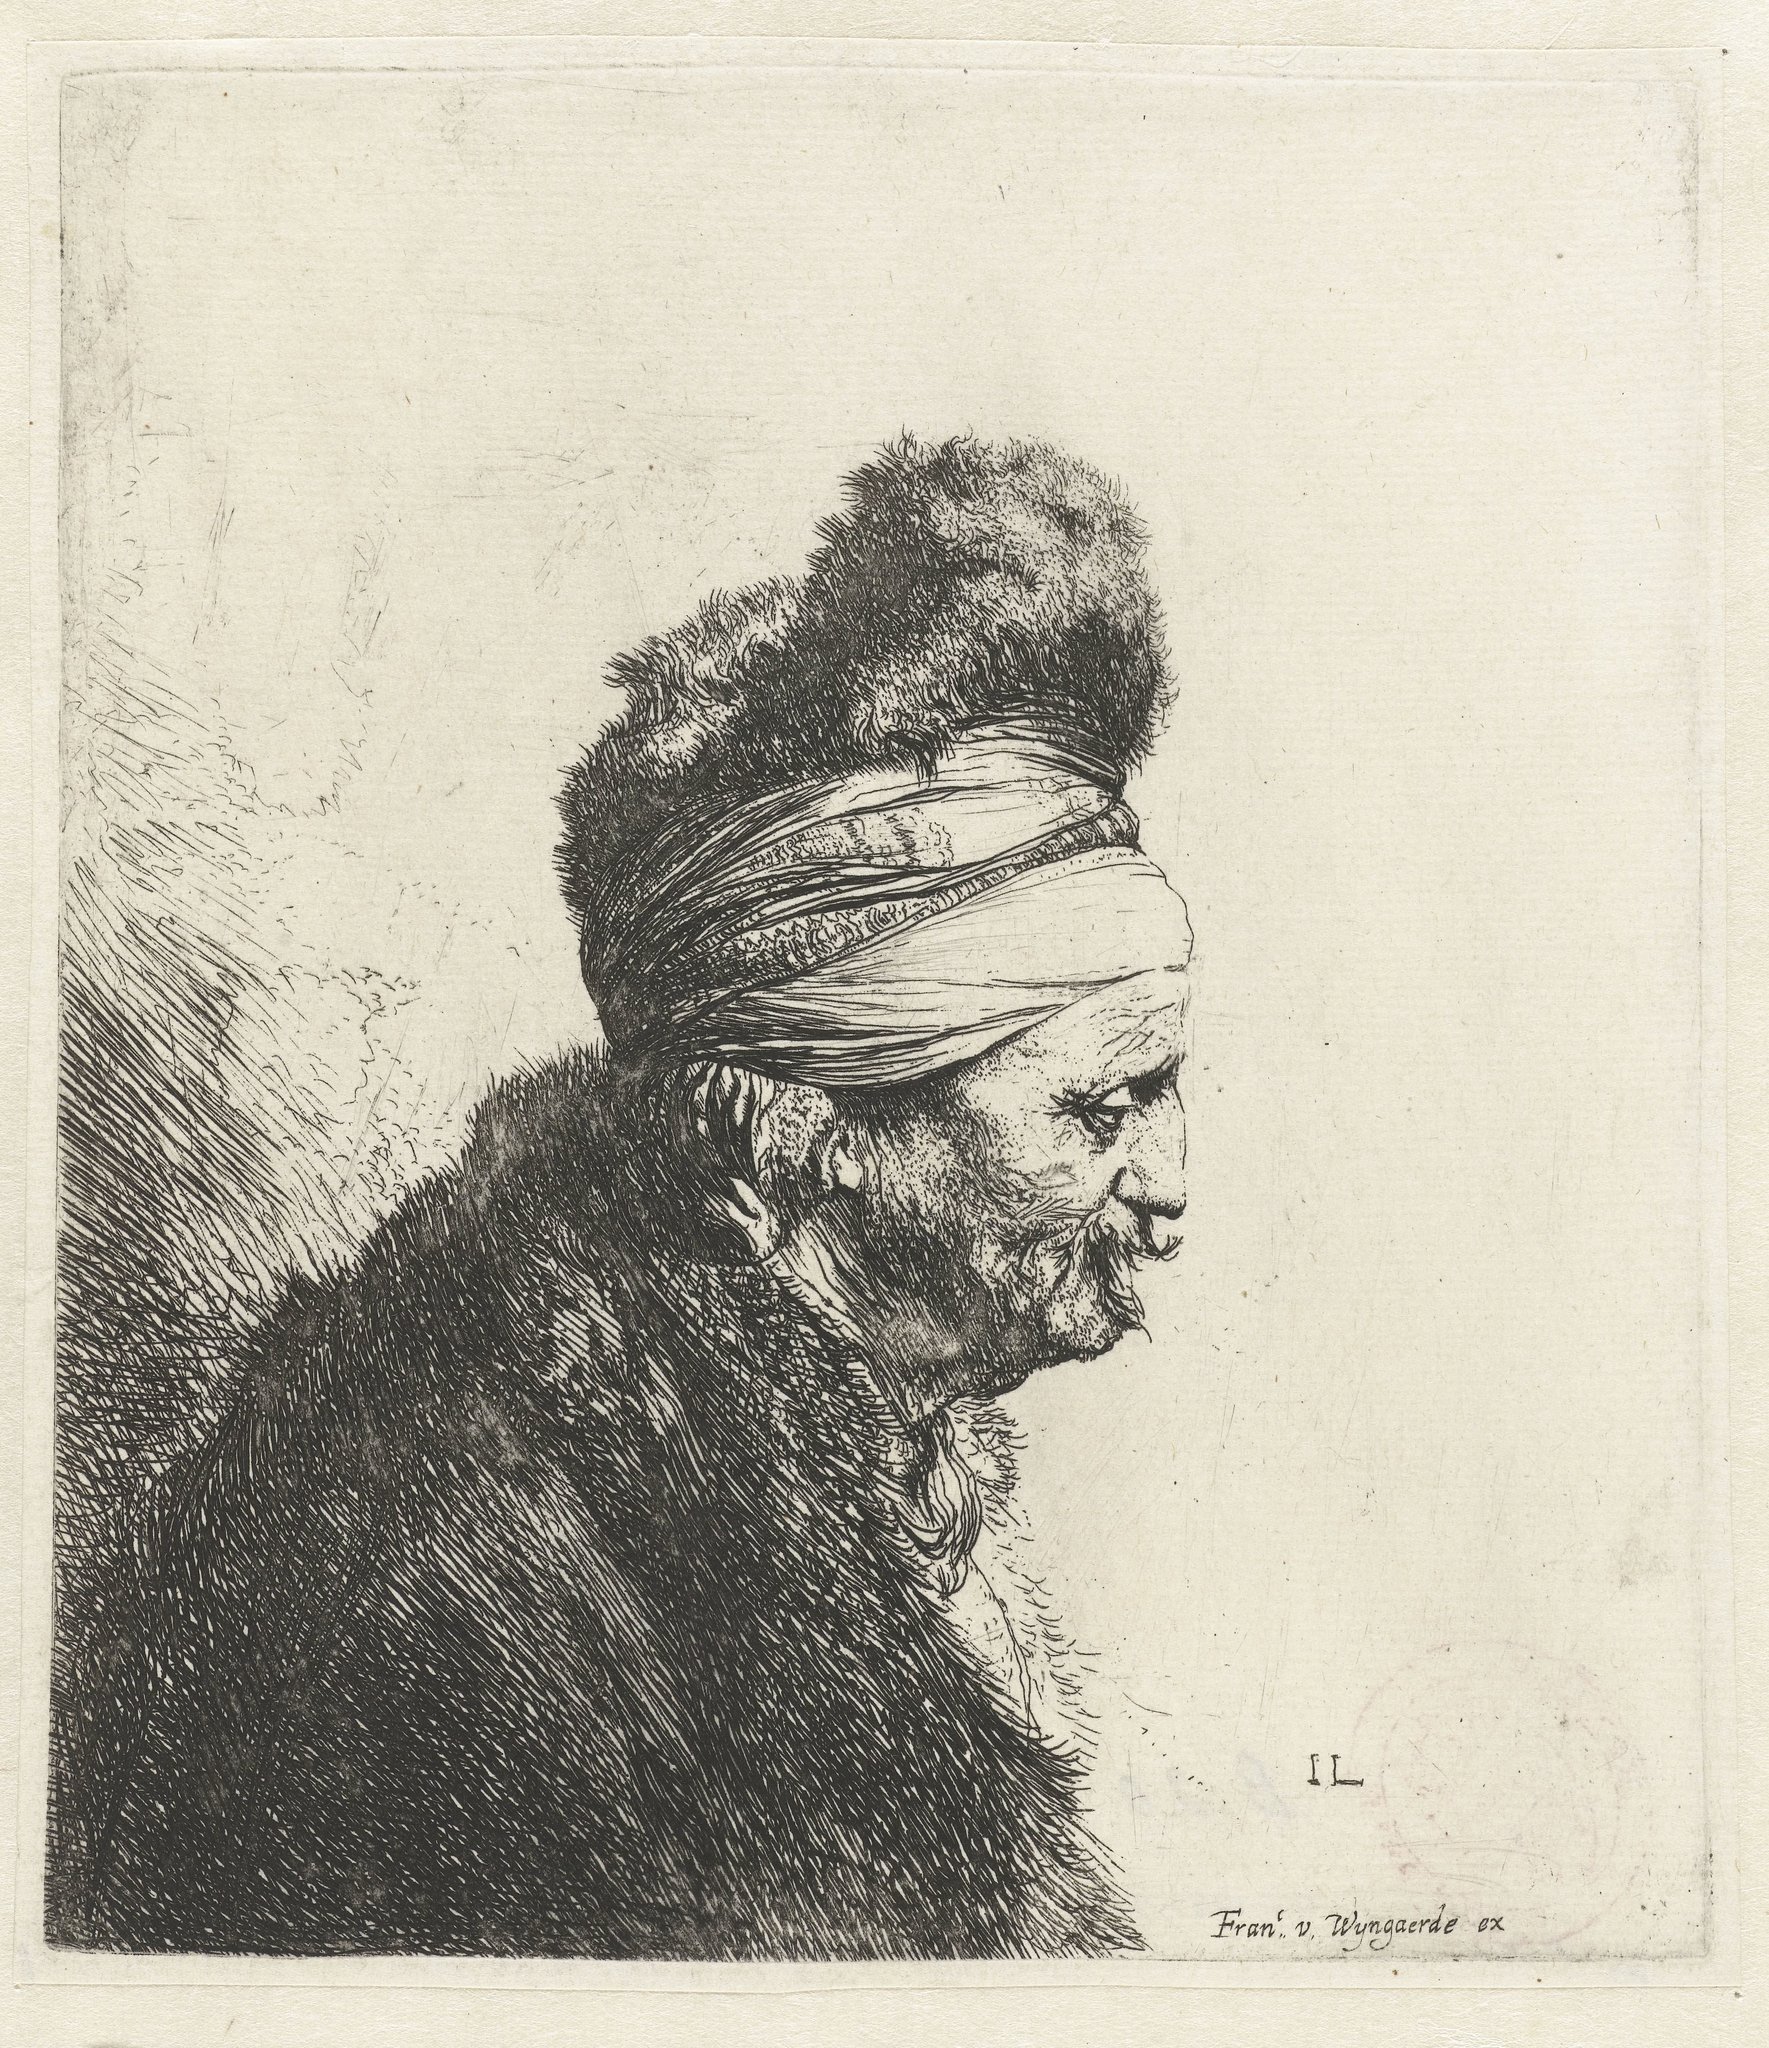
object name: print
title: Diverse tronikens geets van J. L.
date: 1630-1632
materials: paper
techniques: etching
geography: leiden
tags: human races; peoples; nationalities (+ costume), fashion, clothing (+ fur used for clothes), male sex; man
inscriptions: collector's mark: Lugt 240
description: Een staat voor de eerste staat waarop de initialen en het nummer 3 ontbreken wordt bij Hollstein niet vermeld, er zijn nu 5 staten van deze prent bekend.